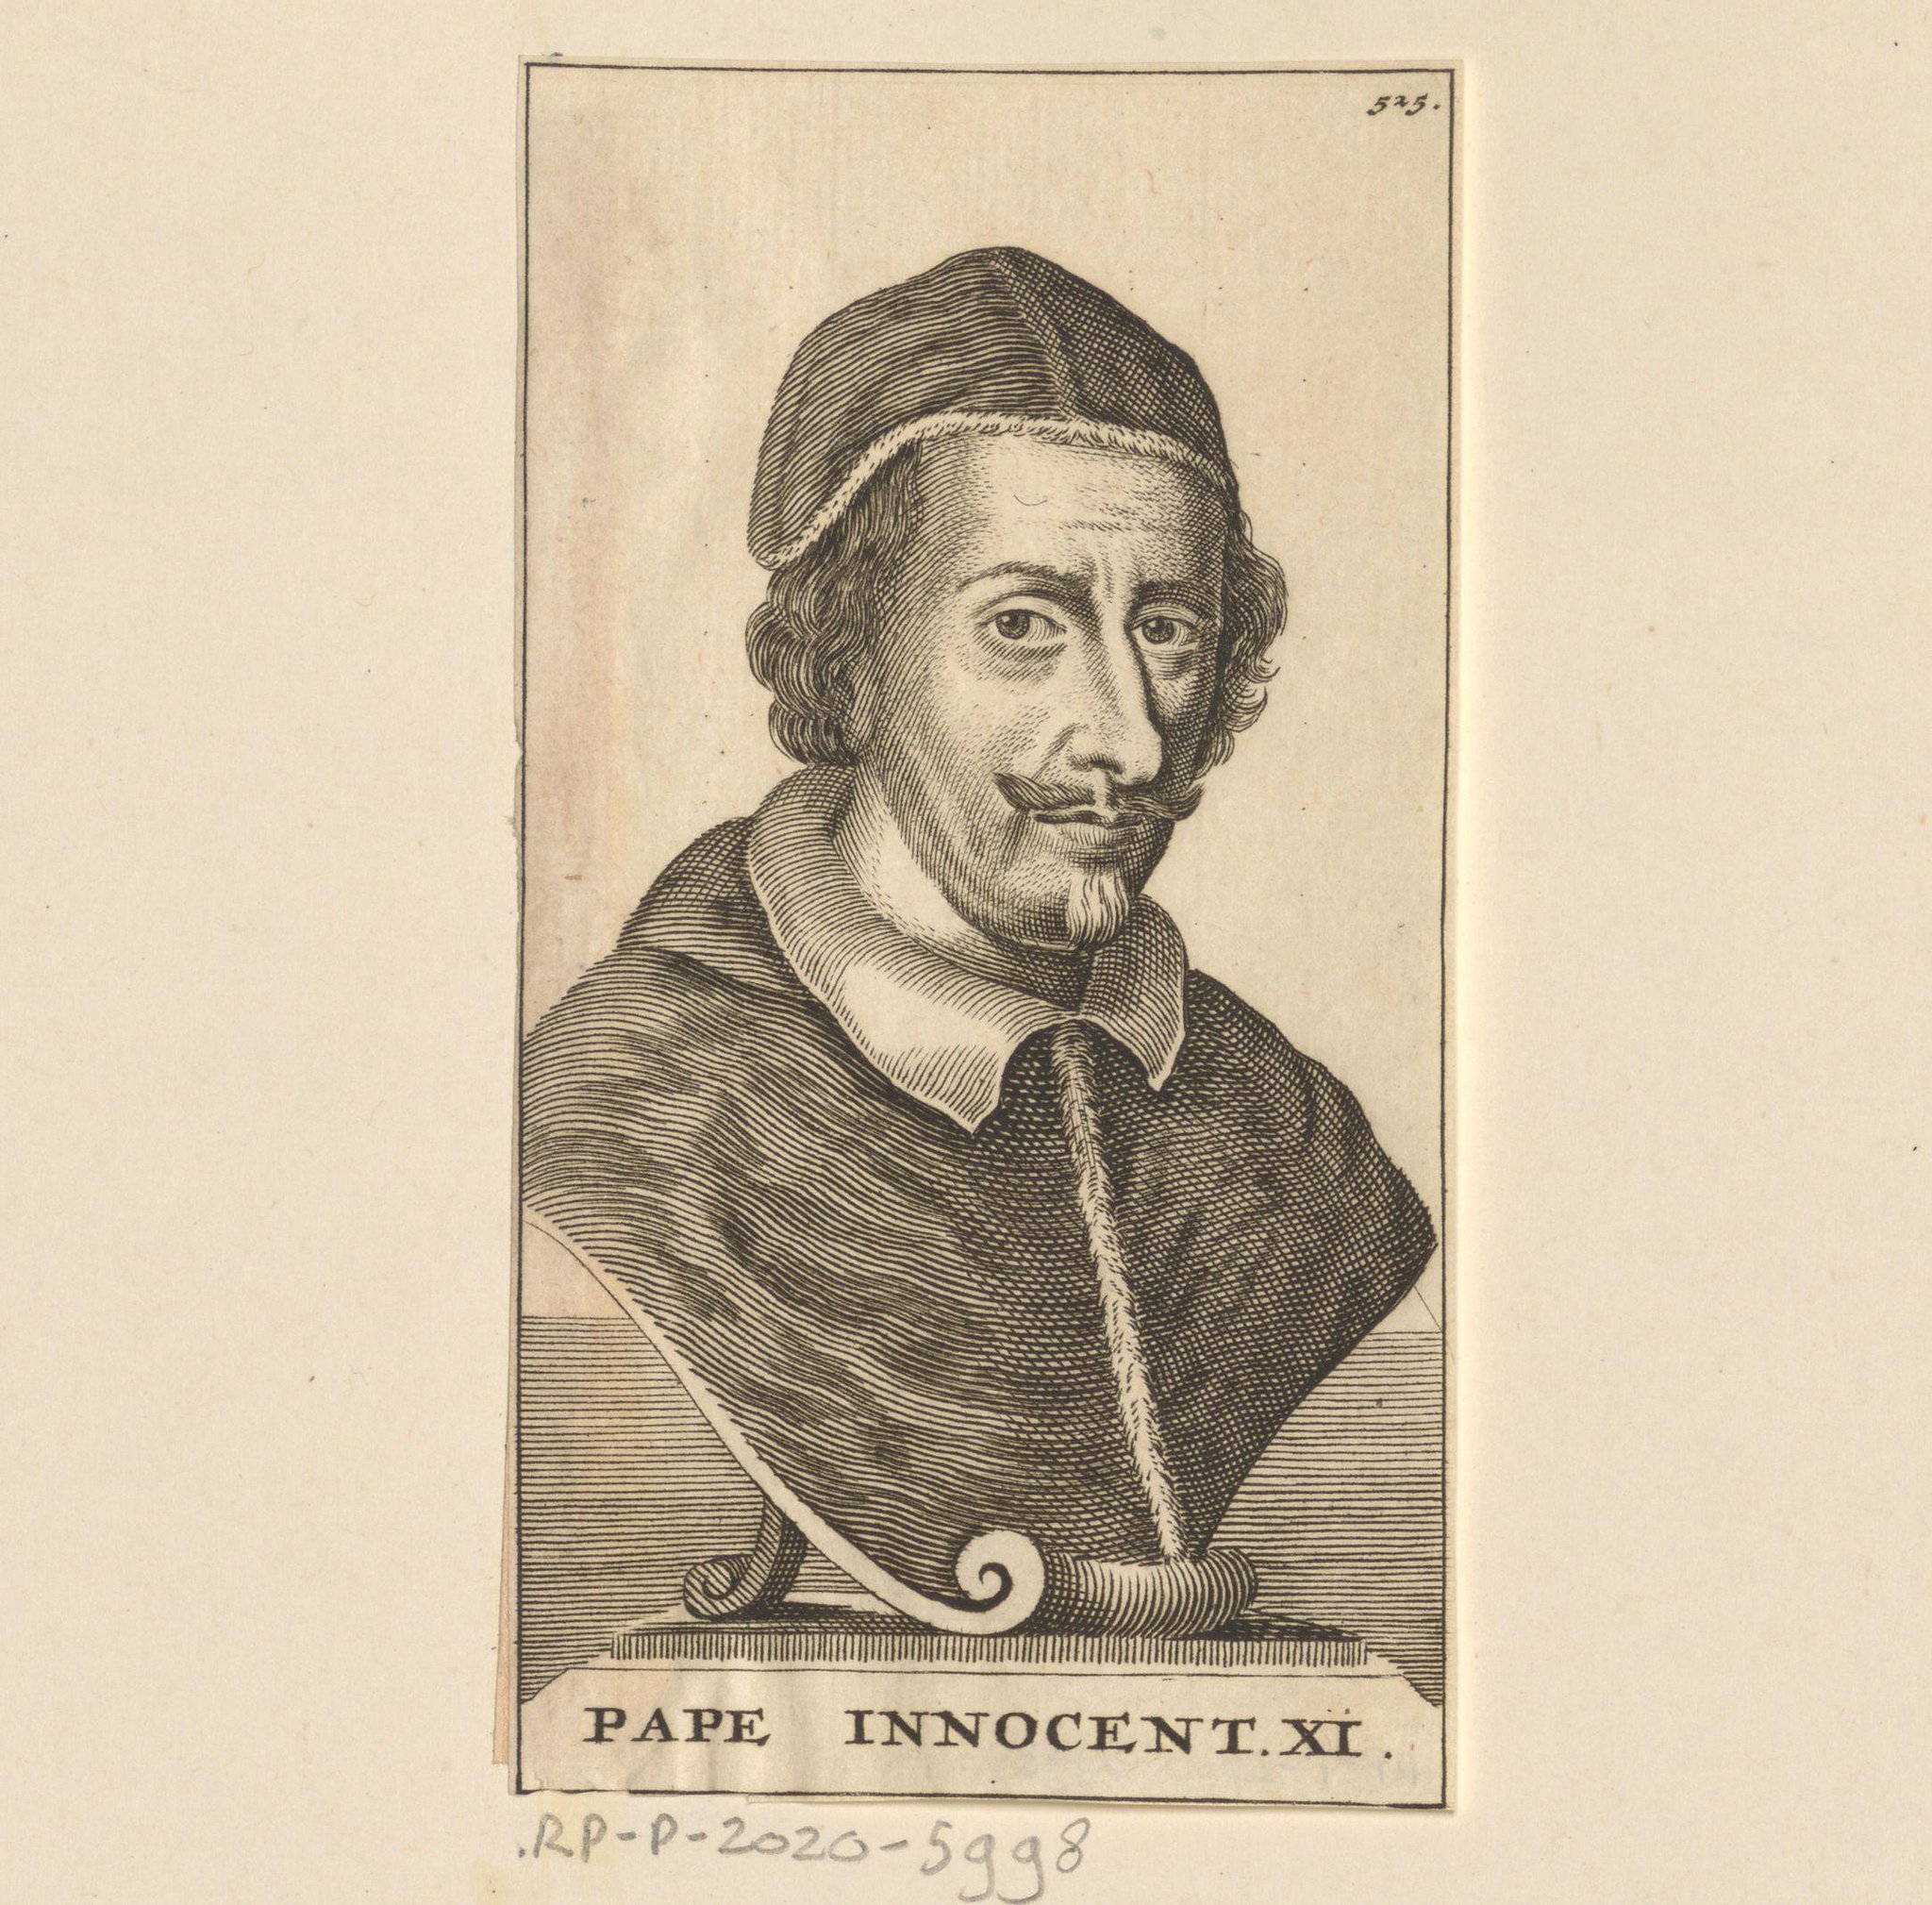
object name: print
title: Portret van paus Innocentius XI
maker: Anonymous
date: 1676-1750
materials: paper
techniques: engraving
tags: clergyman, innocentius xi, historical persons, pope